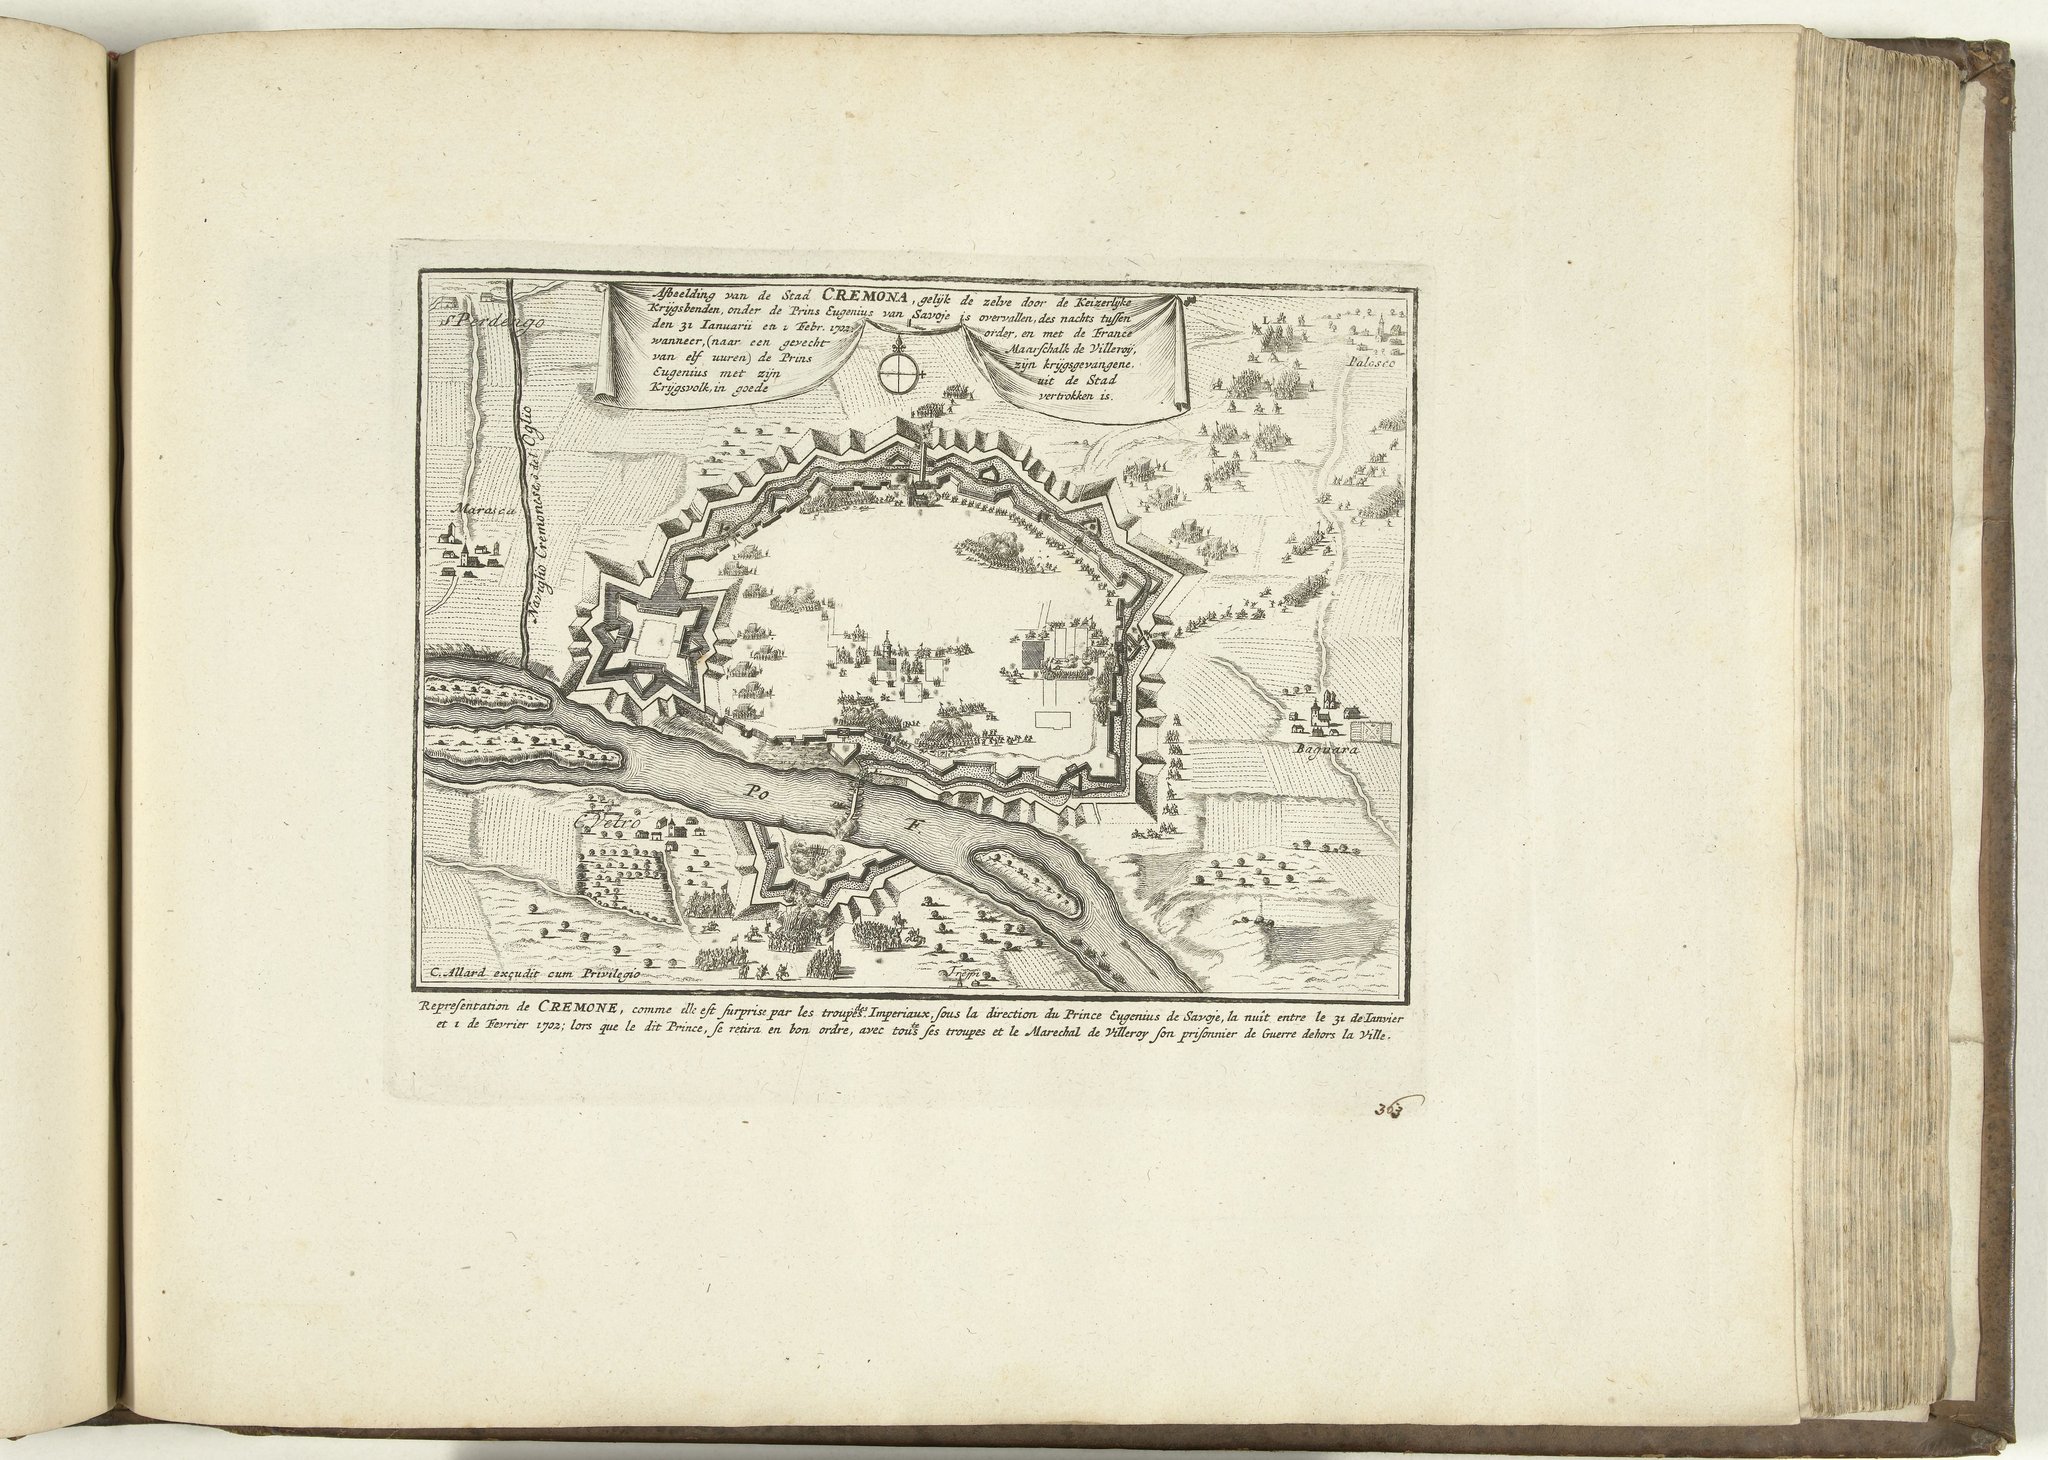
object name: print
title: Inname van Cremona, 1702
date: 1726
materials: paper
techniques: etching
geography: leiden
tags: capture of city (after the siege), maps of cities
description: Plattegrond van Cremona, ingenomen door het keizerlijke leger onder prins Eugenius van Savoye in de nacht van 31 januari op 1 februari 1702. Kort daarop heroveren de Fransen de stad. Plaat nr. 363 in deel XV van het prentwerk: Les Forces de l'Europe, Asie, Afrique et Amerique ... Comme aussi les Cartes des Côtes de France et d'Espagne uit 1726, dit tweede deel met 271 met de hand genummerde platen van vermaarde sterke steden en vestingen in het kader van de Spaanse Successieoorlog 1701-1713. Voor het merendeel zijn deze platen gekopieerd naar de anonieme Franse platen van vermaarde sterke steden en vestingen: in Les forces de l'Europe en in: Le theatre de la guerre, dans les Pays-Bas, beide oorspronkelijk uitgegeven door Nicolas de Fer te Parijs (1693-1697) in het kader van de Negenjarige Oorlog. Titels in het Nederlands en Frans.